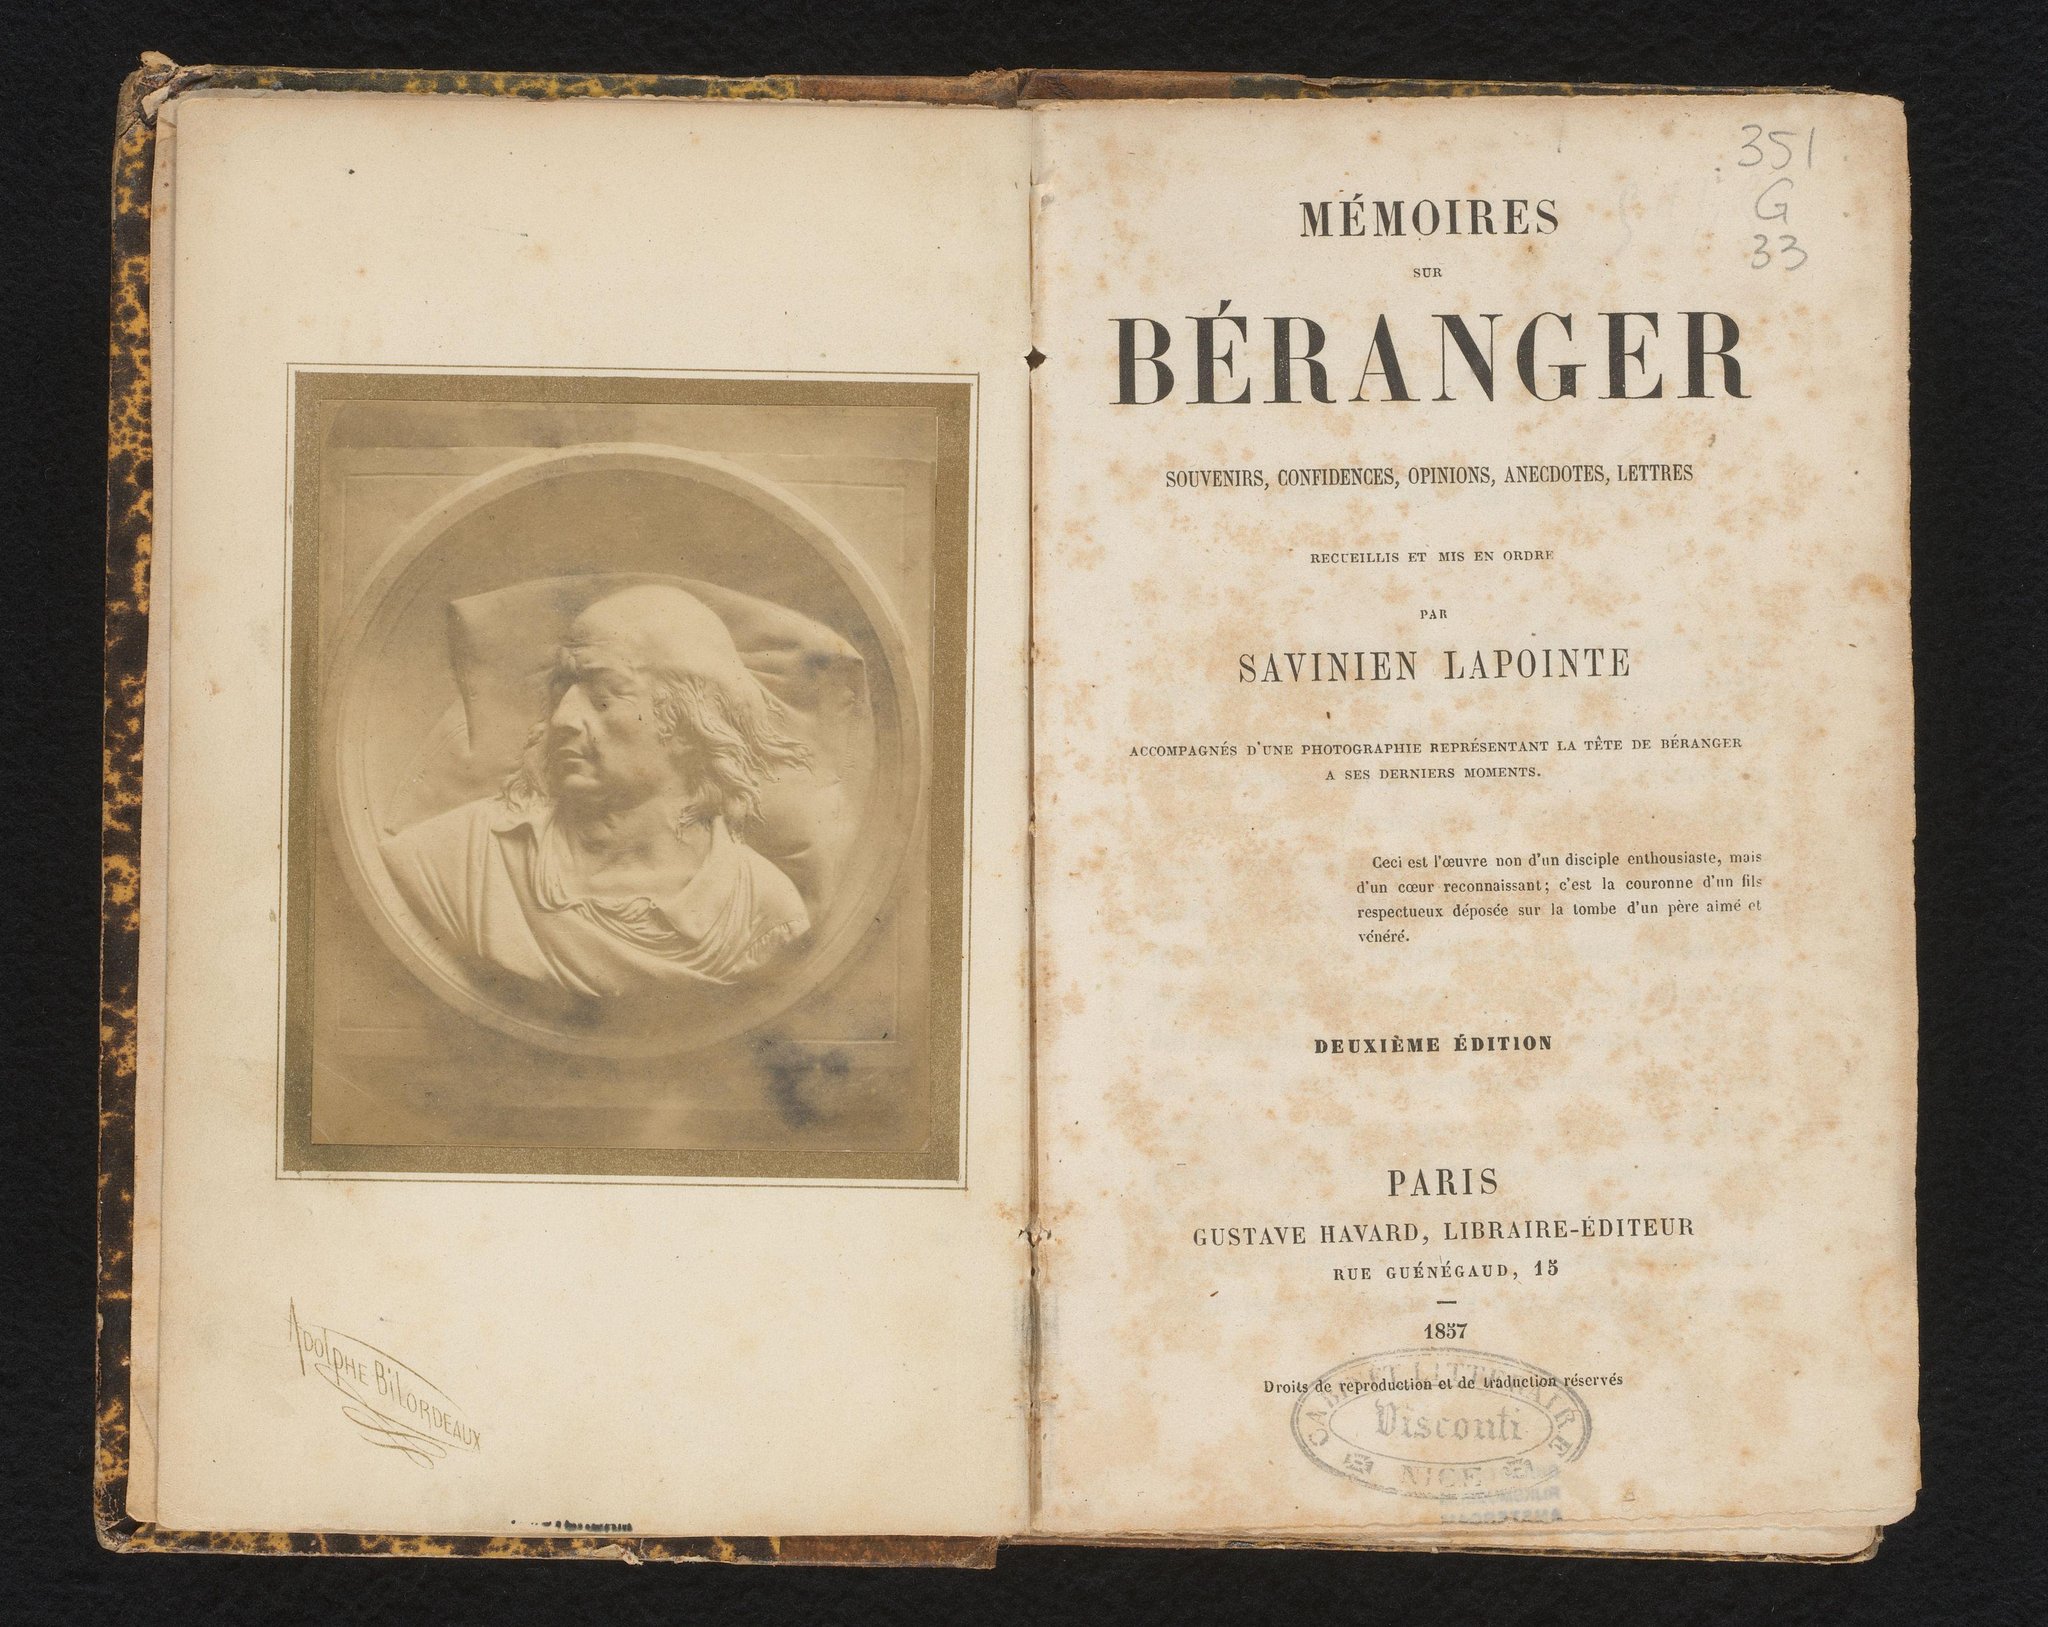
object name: page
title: Fotoreproductie van een portretreliëf van Pierre-Jean de Béranger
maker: adolphe bilordeaux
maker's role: draughtsman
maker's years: 1807-1872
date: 1852-1857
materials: paper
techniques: albumen print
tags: paris, pierre-jean de béranger, portrait of a writer